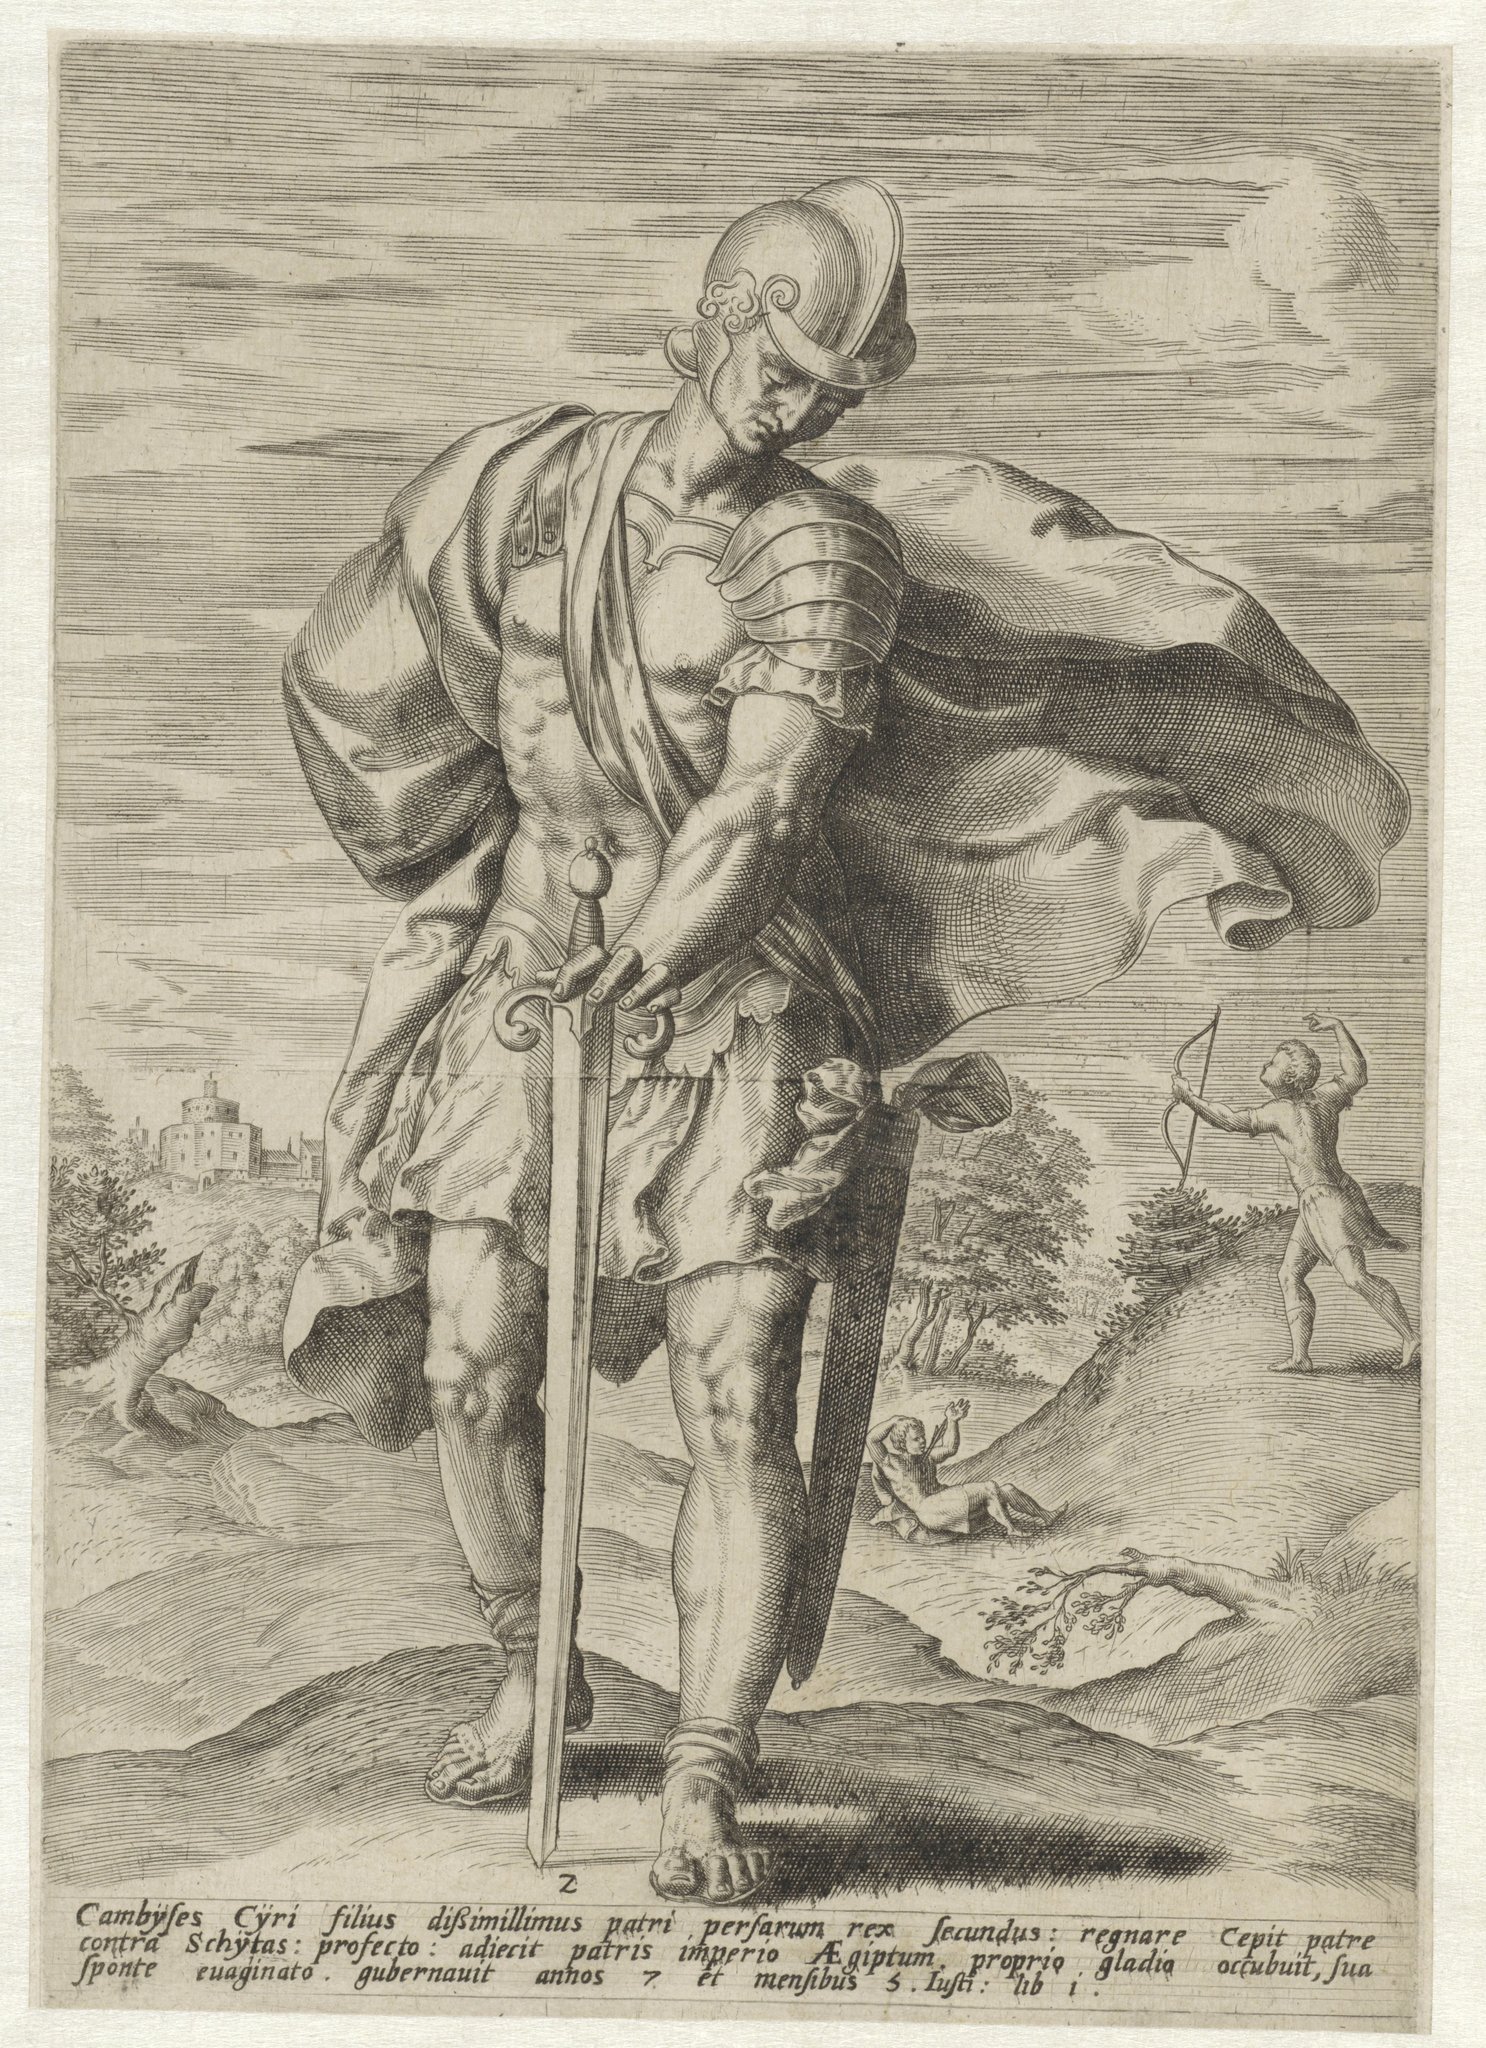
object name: print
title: Perzische koningen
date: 1547-1585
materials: paper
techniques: engraving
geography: antwerp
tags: cambyses shoots prexaspes' son with an arrow, (story of) cambyses - portrait of person from classical history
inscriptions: collector's mark: Lugt 2760, collector's mark: Lugt 2228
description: Koning Cambyses van Perzië staande met zijn hand op zijn zwaard. Op de achtergrond is te zien hoe Cambyses de zoon van Prexaspes doodt met een pijl. Onder de voorstelling een drieregelige tekst in het Latijn.